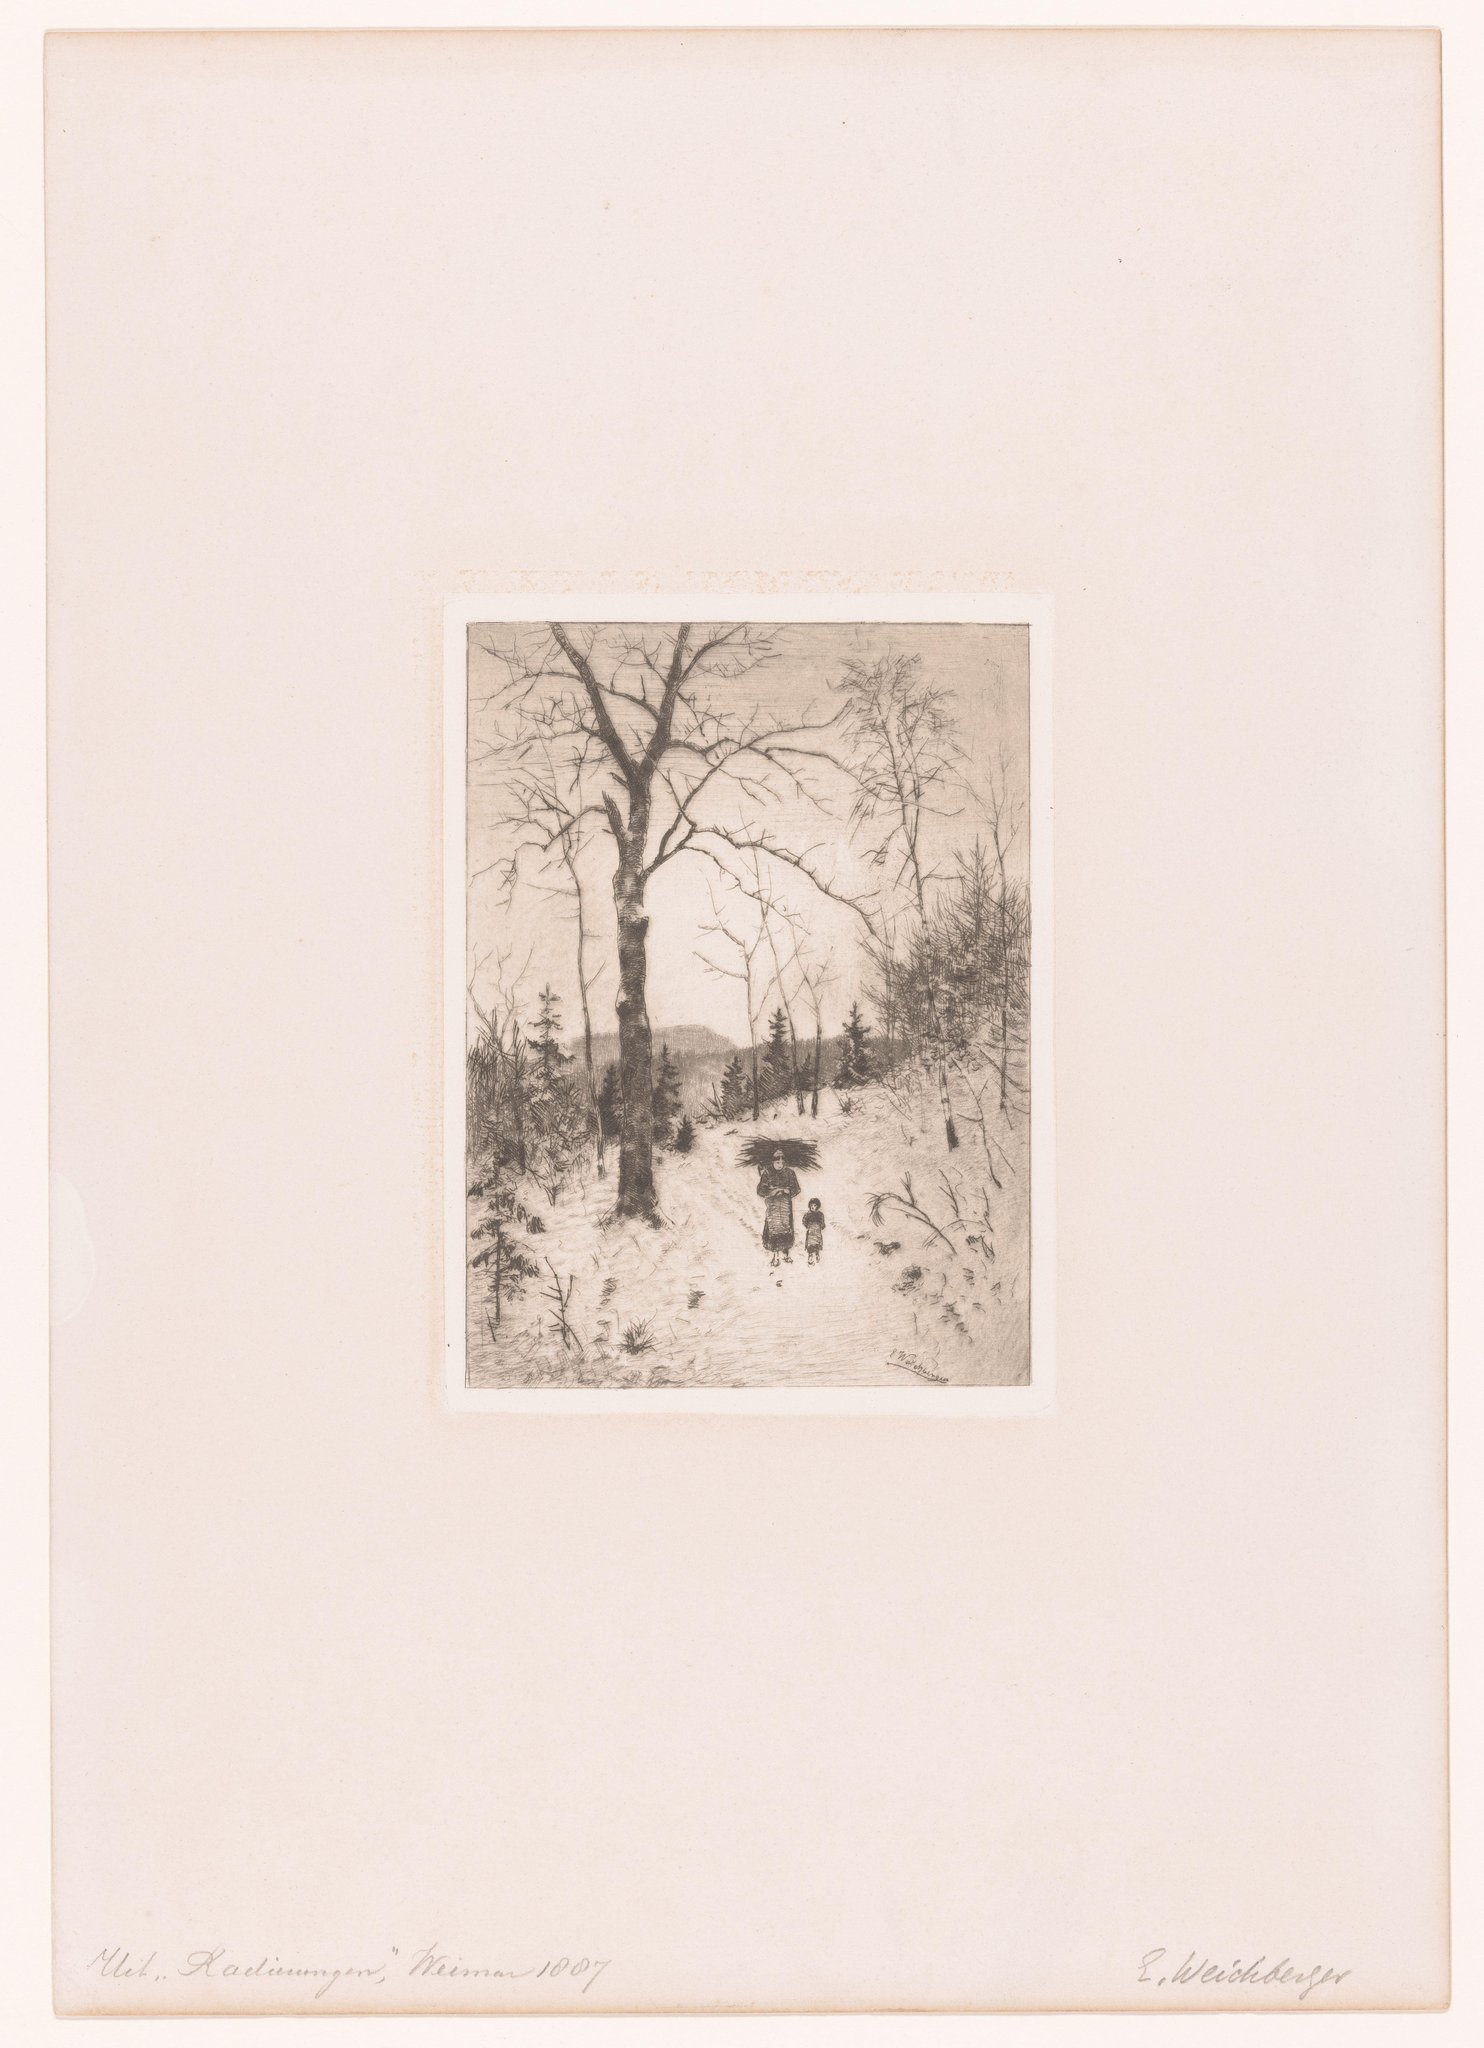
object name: print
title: Hout sprokkelende vrouw met kind in een besneeuwd bos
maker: eduard weichberger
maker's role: print maker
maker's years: 1843-1913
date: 1887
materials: paper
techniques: etching, intaglio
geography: weimar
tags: woodgathering, woodgatherer, snow, trees: pine, mother and child(ren), woman and child(ren) (family group)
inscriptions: inscription: ‘Uit "Radierungen", Weimar 1887’, collector's mark: Lugt 2228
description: Prent maakt deel uit van een groep prenten die tussen 1880 en 1888 werd uitgegeven door het Gesellschaft für Radierkunst te Weimar.